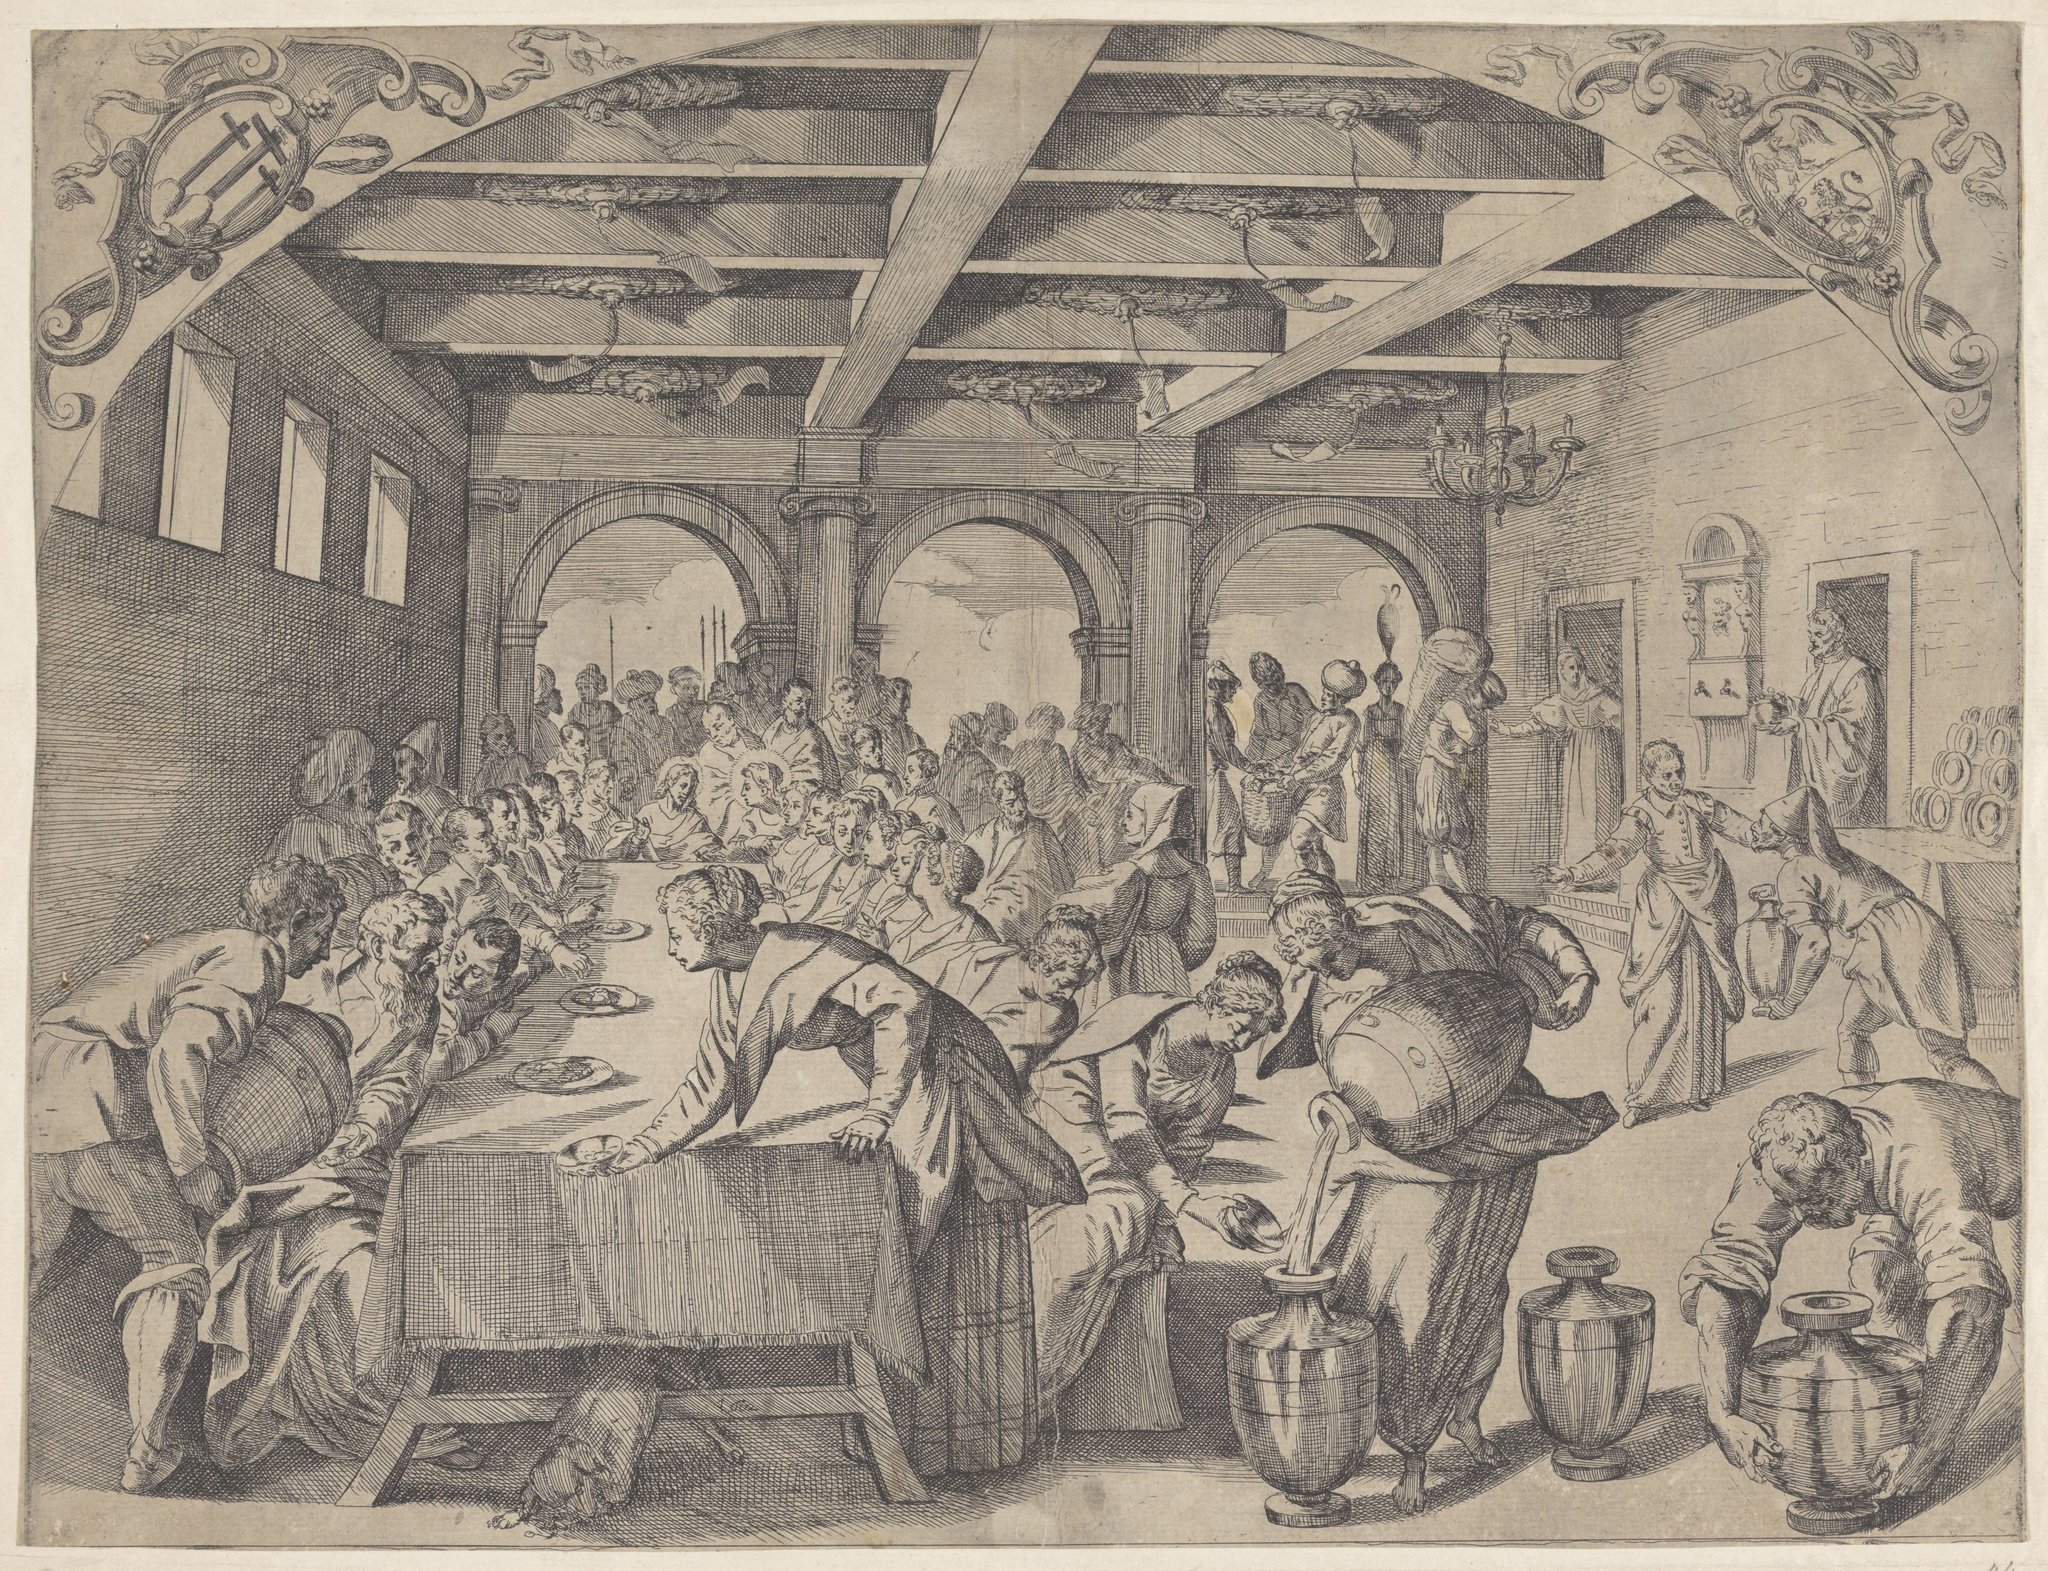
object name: print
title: De bruiloft te Kana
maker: odoardo fialetti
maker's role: painter, print maker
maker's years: 1573-1638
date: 1583-1638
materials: paper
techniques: etching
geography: italy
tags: christ orders (six) jars to be filled with water ~ marriage-feast at cana, mary tells christ that there is no more wine ~ marriage-feast at cana, the marriage-feast at cana (john 2:1-11)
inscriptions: collector's mark: Lugt 2228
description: Zicht in een grote zaal met de bruiloft te Kana. Links staat een lange tafel waaraan de bruiloftsgasten zitten en Christus aan het hoofd. Maria zit naast Christus en vertelt hem dat de wijn op is. Op de voorgrond rechts vullen bedienden de wijnvaten met water.